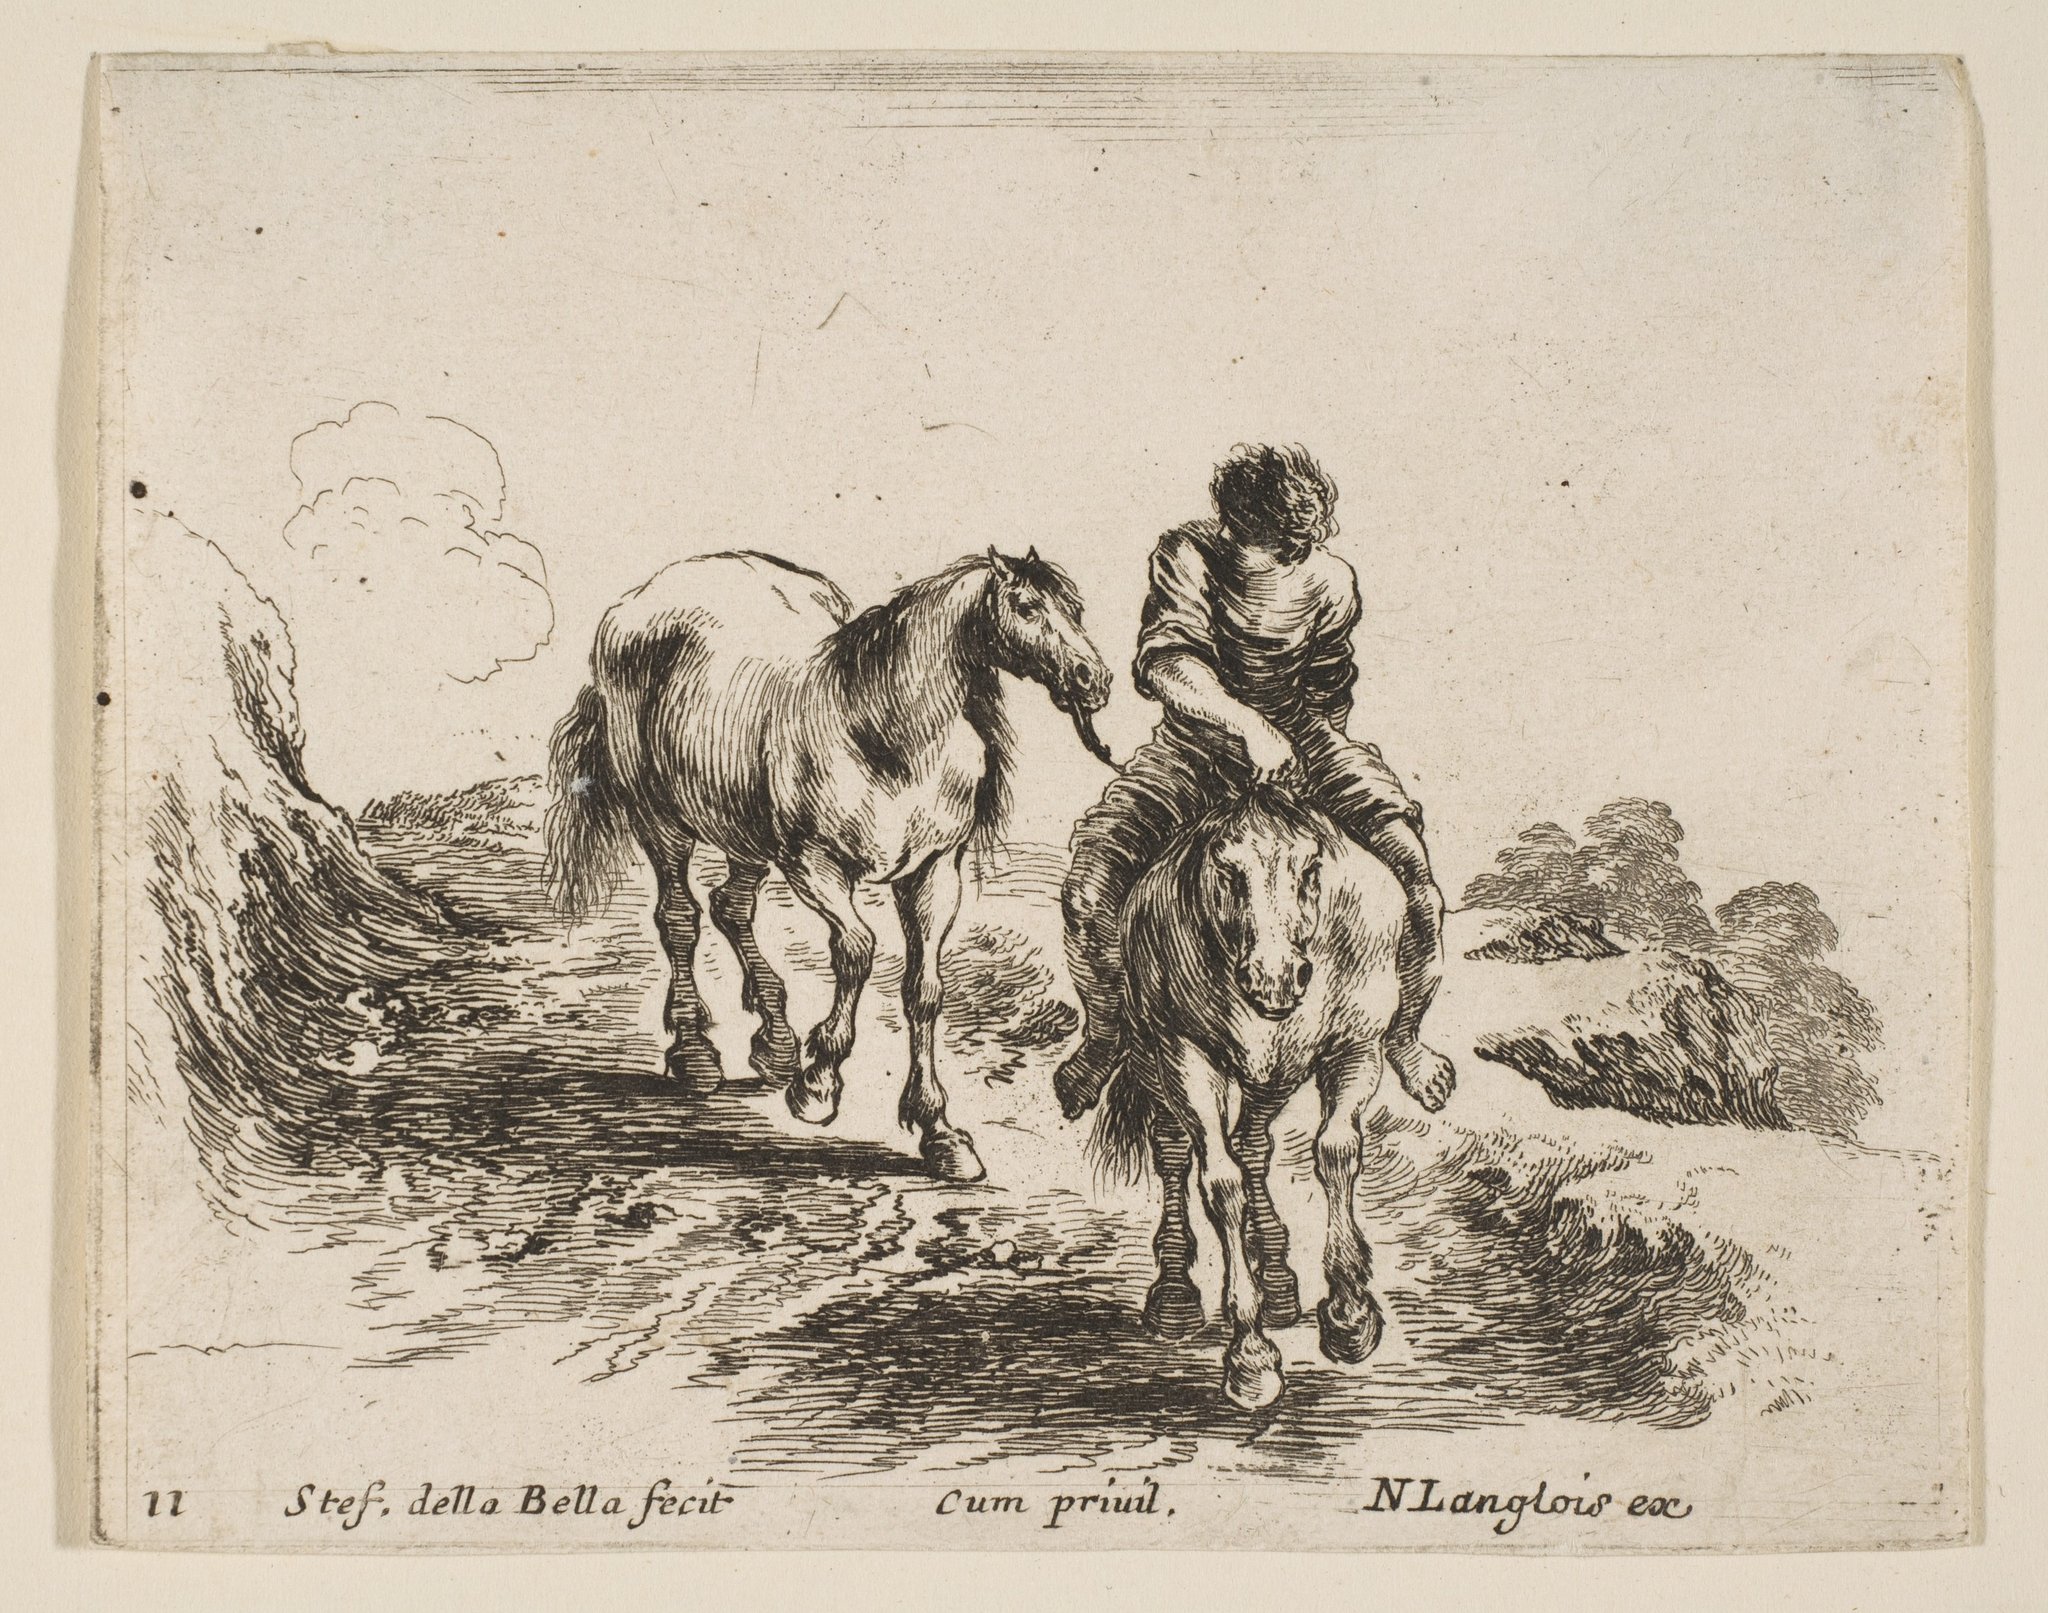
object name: print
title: A young horseman, seen from the front, leading another horse, plate 11 from "Diversi capricci"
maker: stefano della bella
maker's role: artist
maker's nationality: italian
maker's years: 1610-1664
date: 1644-1647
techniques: etching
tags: boys,horses